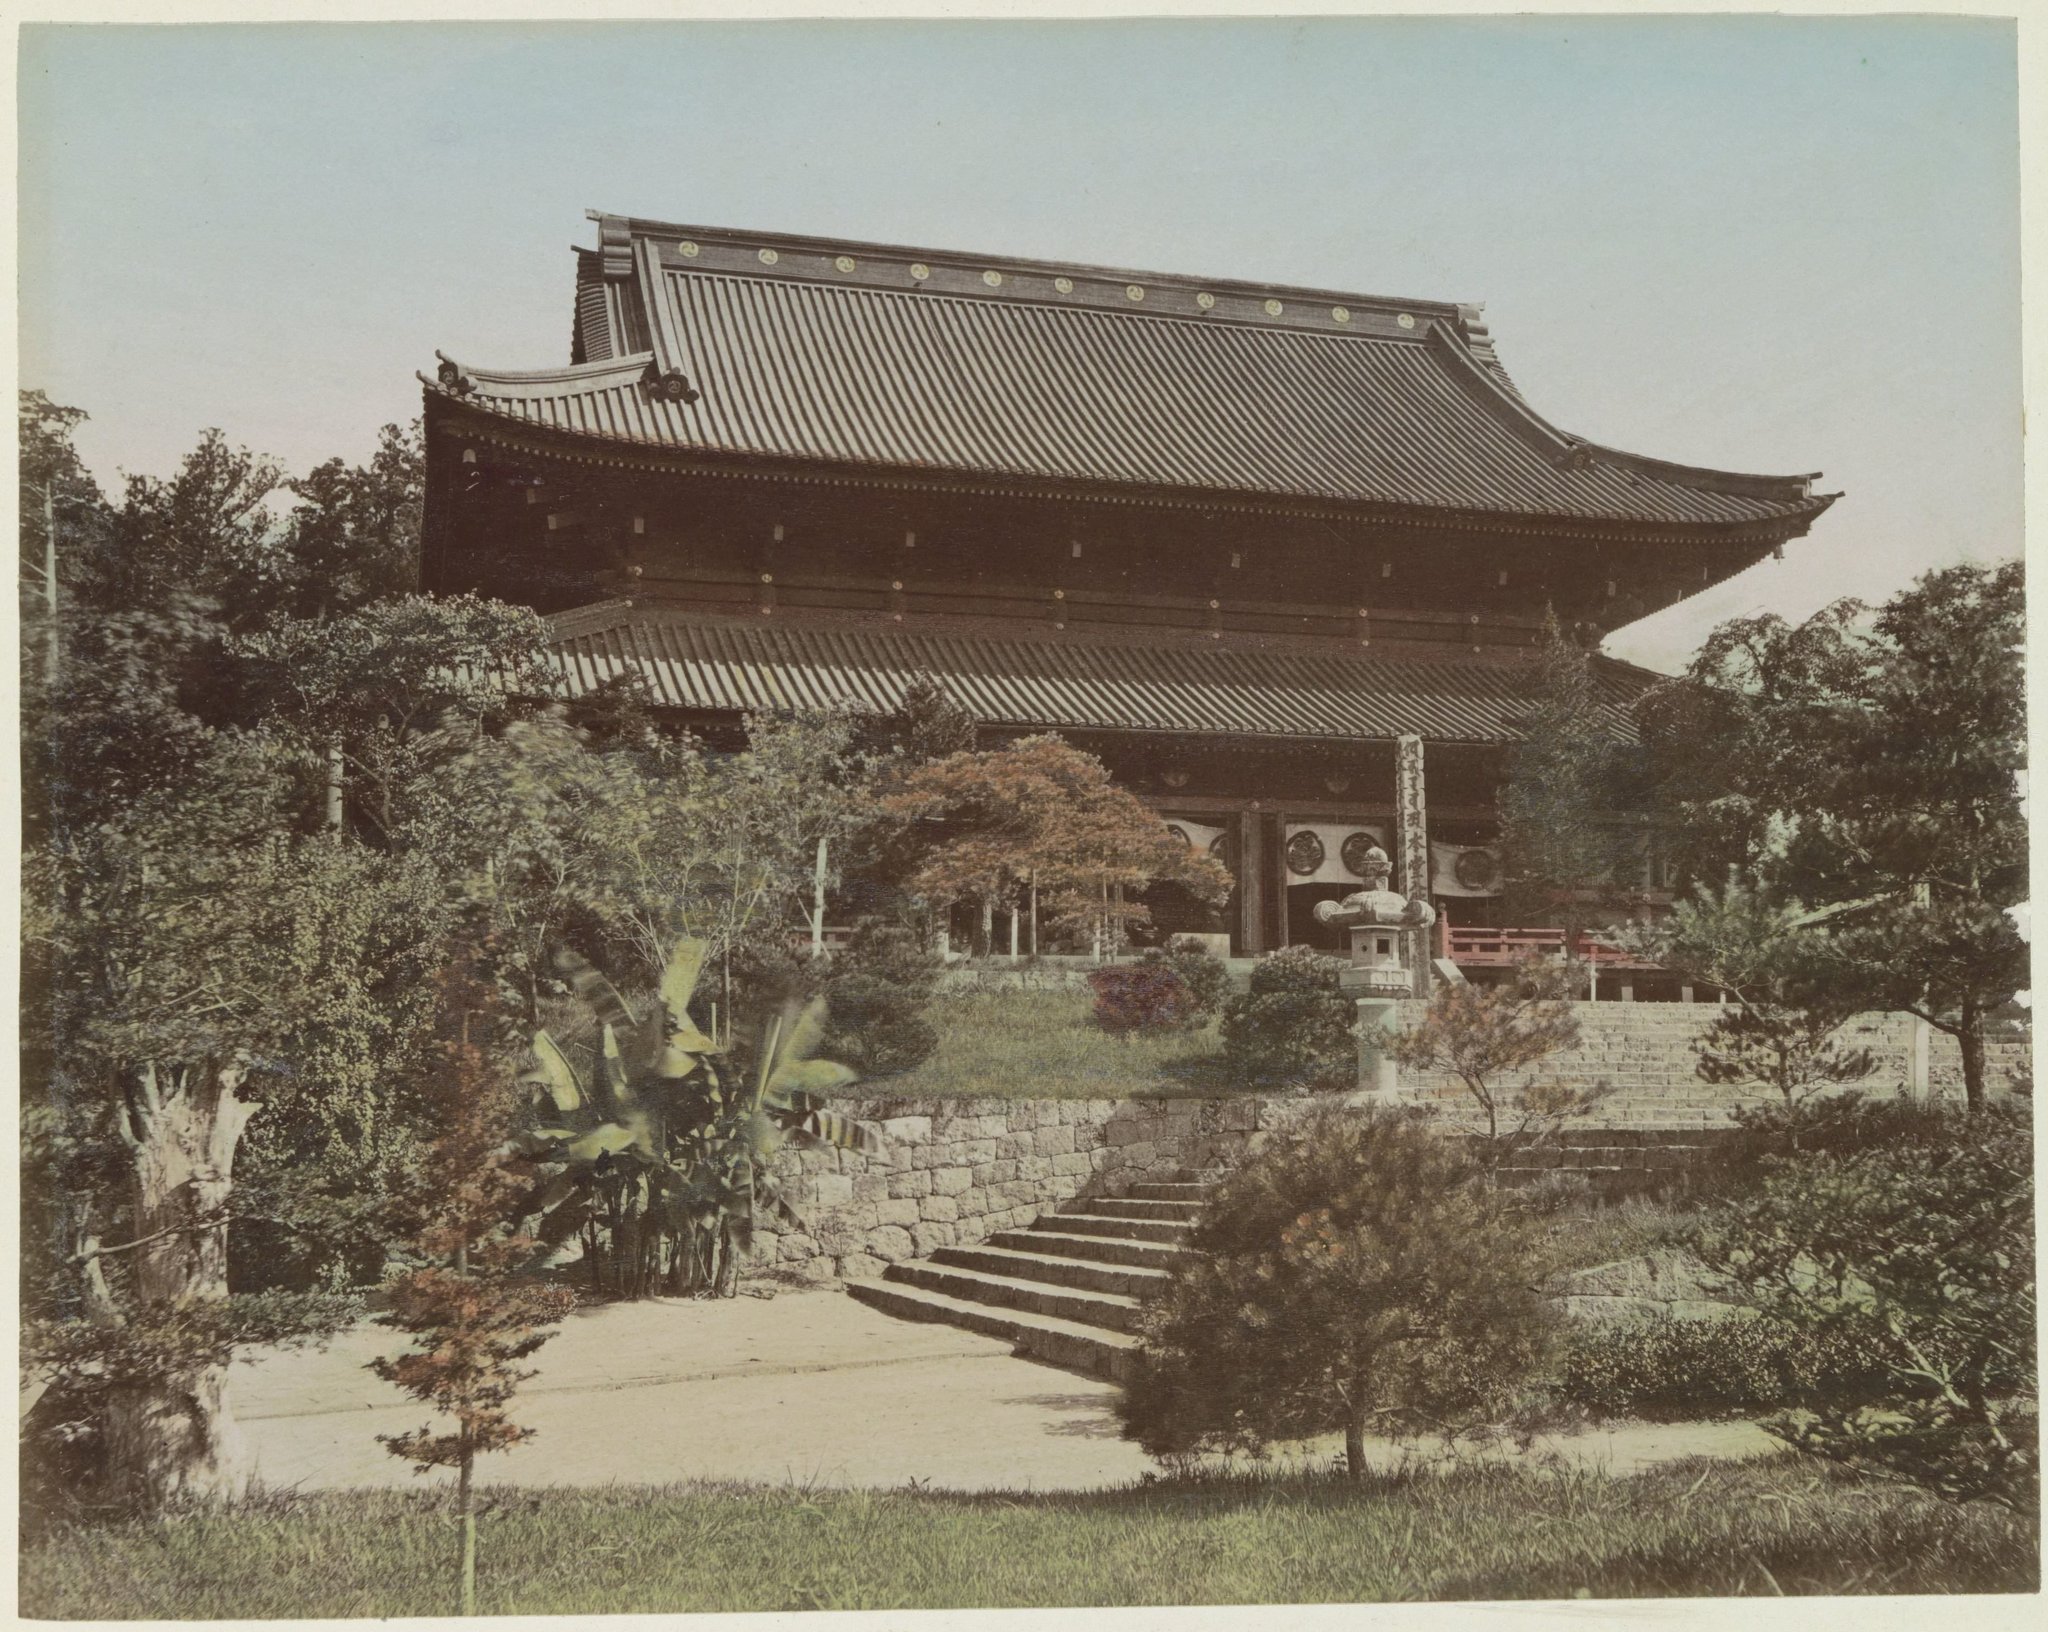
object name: photograph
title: Exterieur van Sanbutsudo, het hoofdgebouw van het Rinnoji-tempelcomplex in Nikko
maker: Anonymous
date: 1870-1900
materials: cardboard, paper, photographic support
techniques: albumen print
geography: nikko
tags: temple, shrine ~ hinduism, buddhism, jainism, roof (of house or building)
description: Onderdeel van Reisalbum met foto's van bezienswaardigheden in Japan.